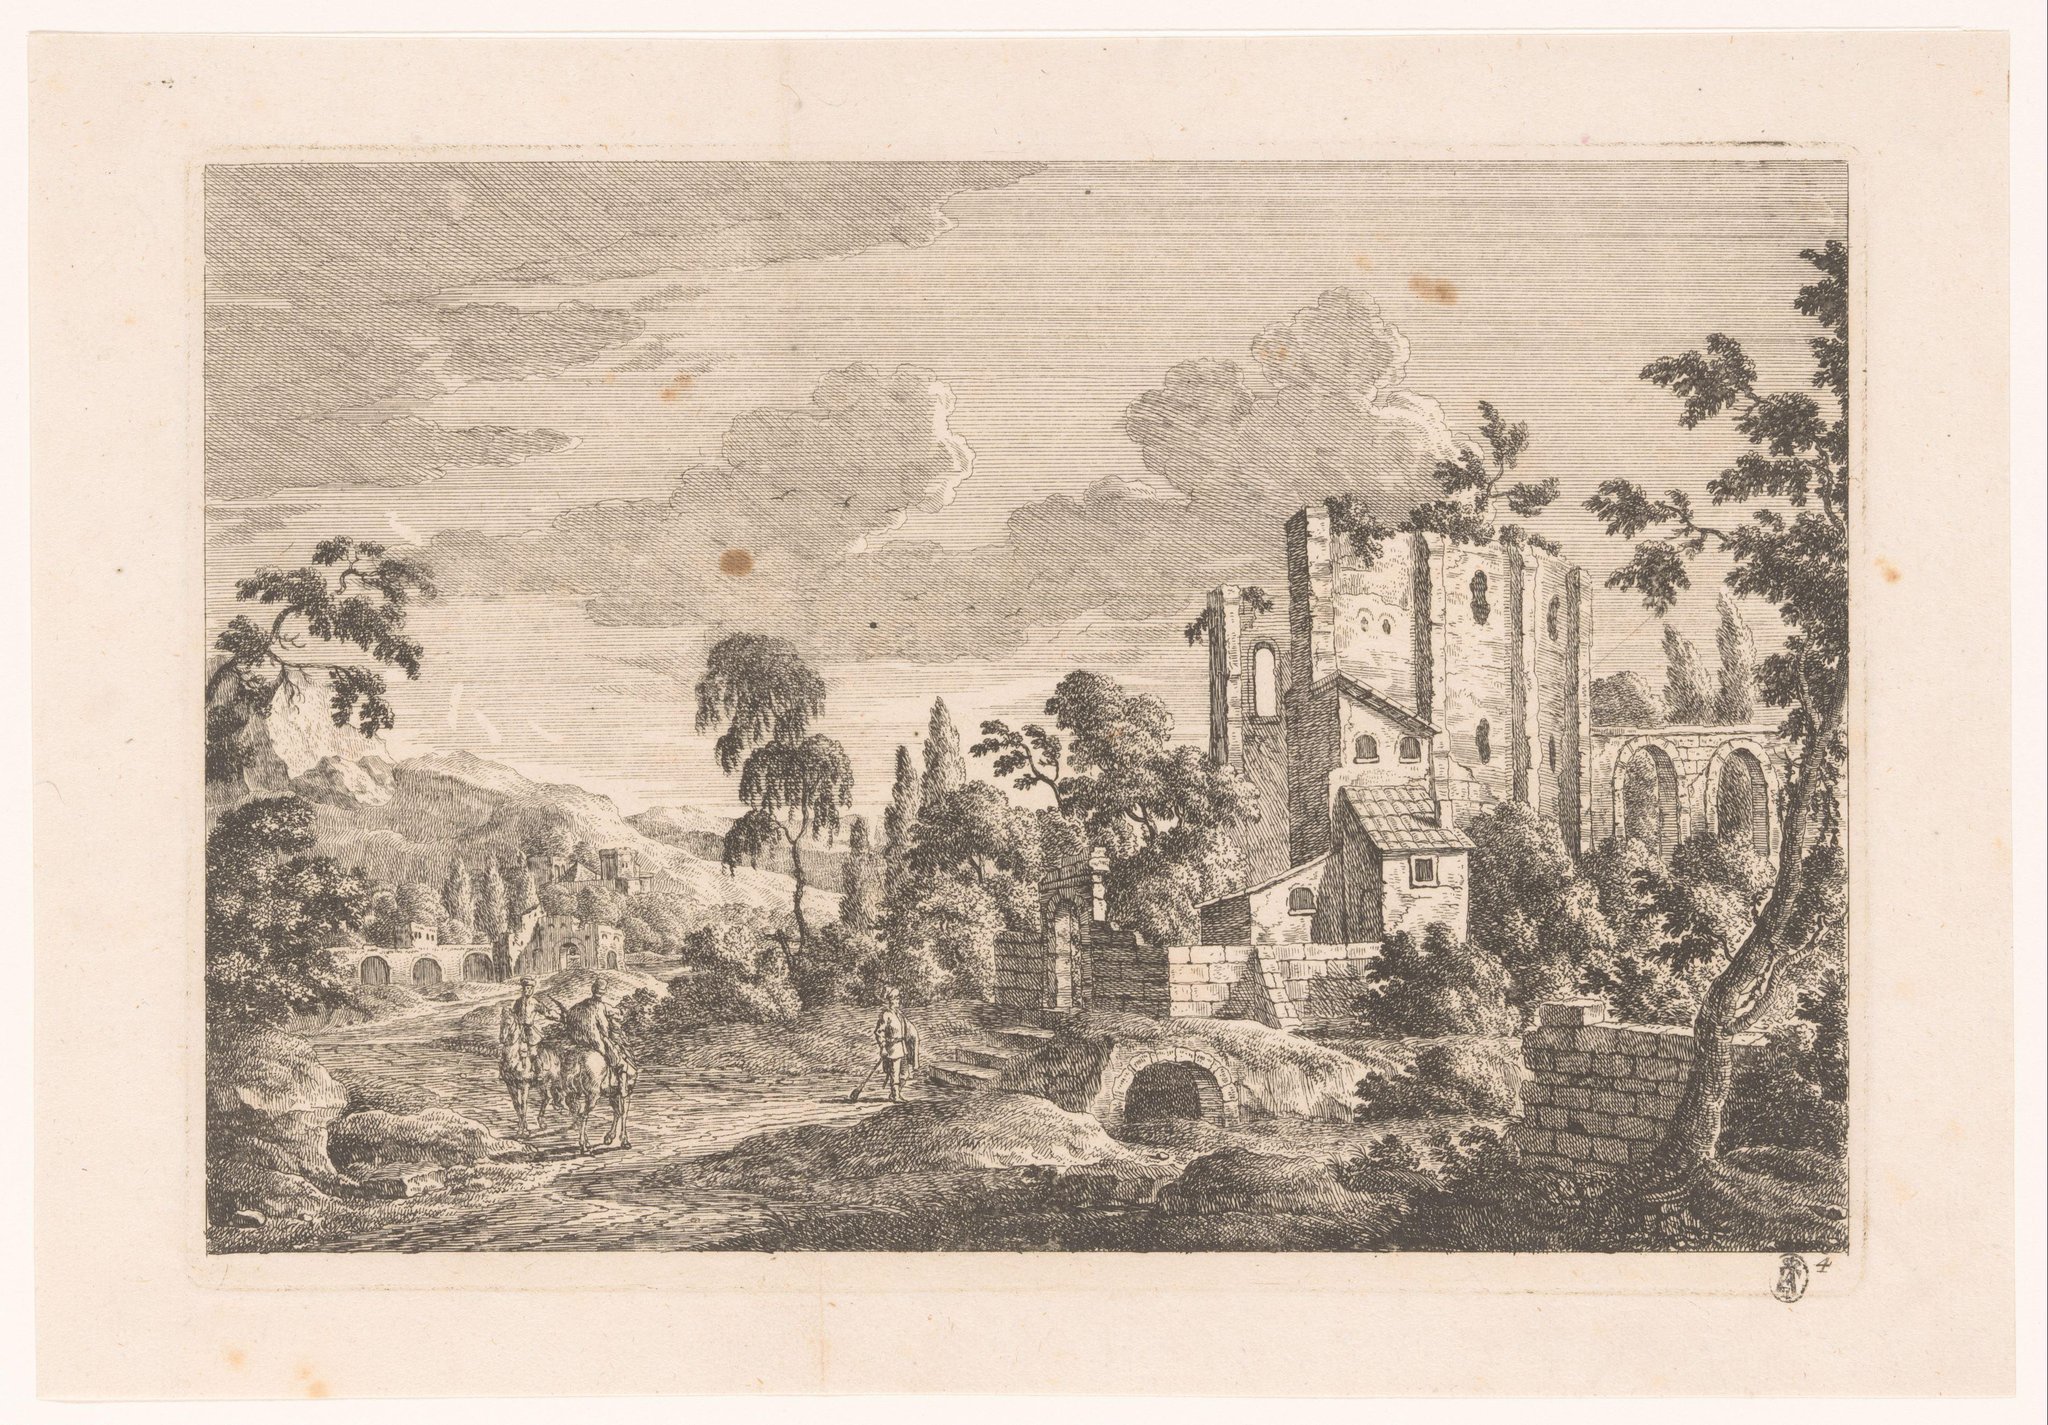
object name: print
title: Landschap met ruïne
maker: monogrammist meg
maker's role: print maker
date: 1700-1730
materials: paper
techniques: etching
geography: germany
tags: landscapes in the temperate zone, landscape with ruins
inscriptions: collector's mark: Lugt 2760, collector's mark: Lugt 2228, collector's mark: Lugt 971